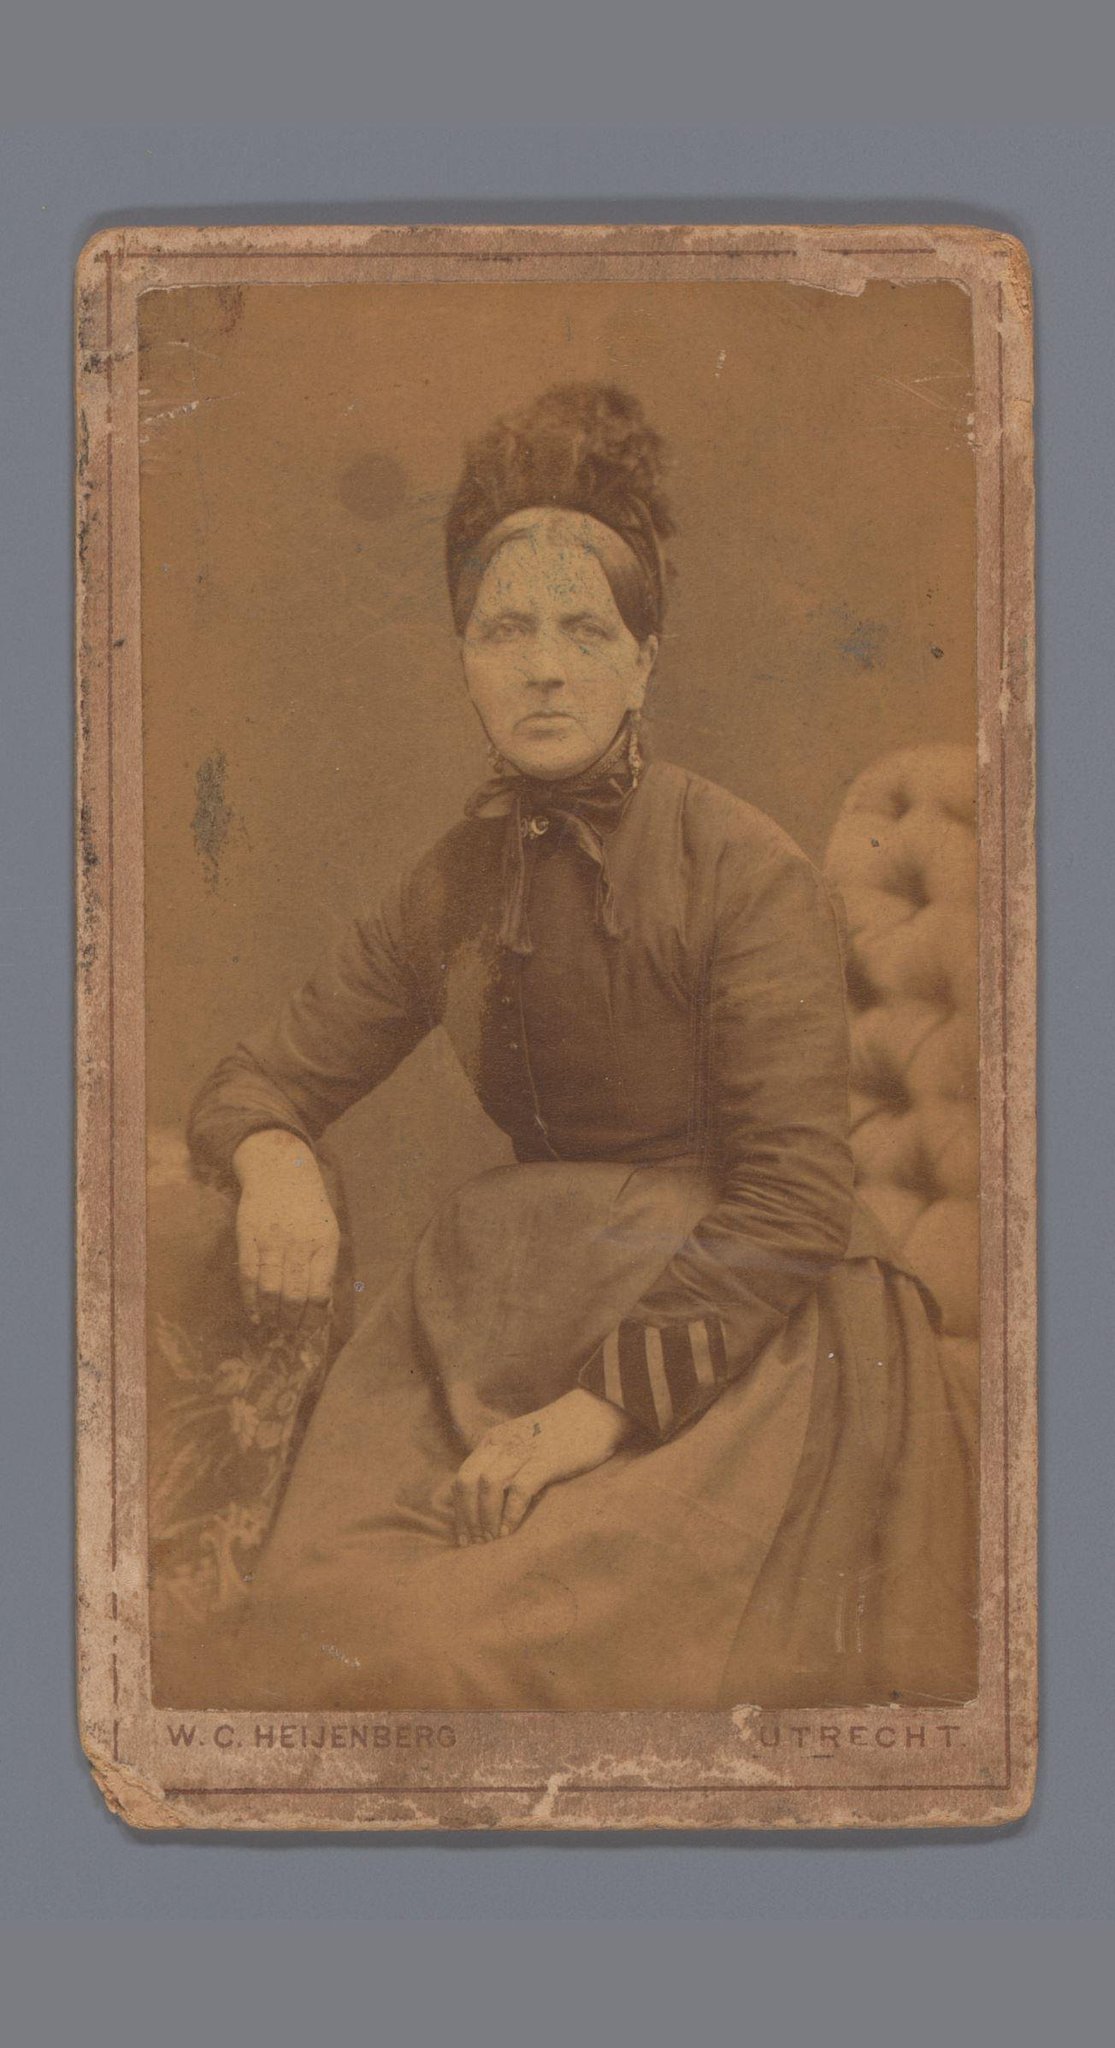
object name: photograph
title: Portret van een onbekende vrouw, aangeduid als Opoe Rijnders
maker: willem carel heijenberg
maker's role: fotograaf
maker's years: 1835-1895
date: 1882-1895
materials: cardboard, paper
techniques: albumen print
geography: amsterdam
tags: historical persons - bb - woman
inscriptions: inscription: ‘opoe Rijnders/ Bekkerstraat’, inscription: ‘W.C. HEIJENBERG/ PHOTOGRAPHE/ UTRECHT/ Nachtegaalstraat No. 40/ Deze Portretten kunnen nabesteld worden.’